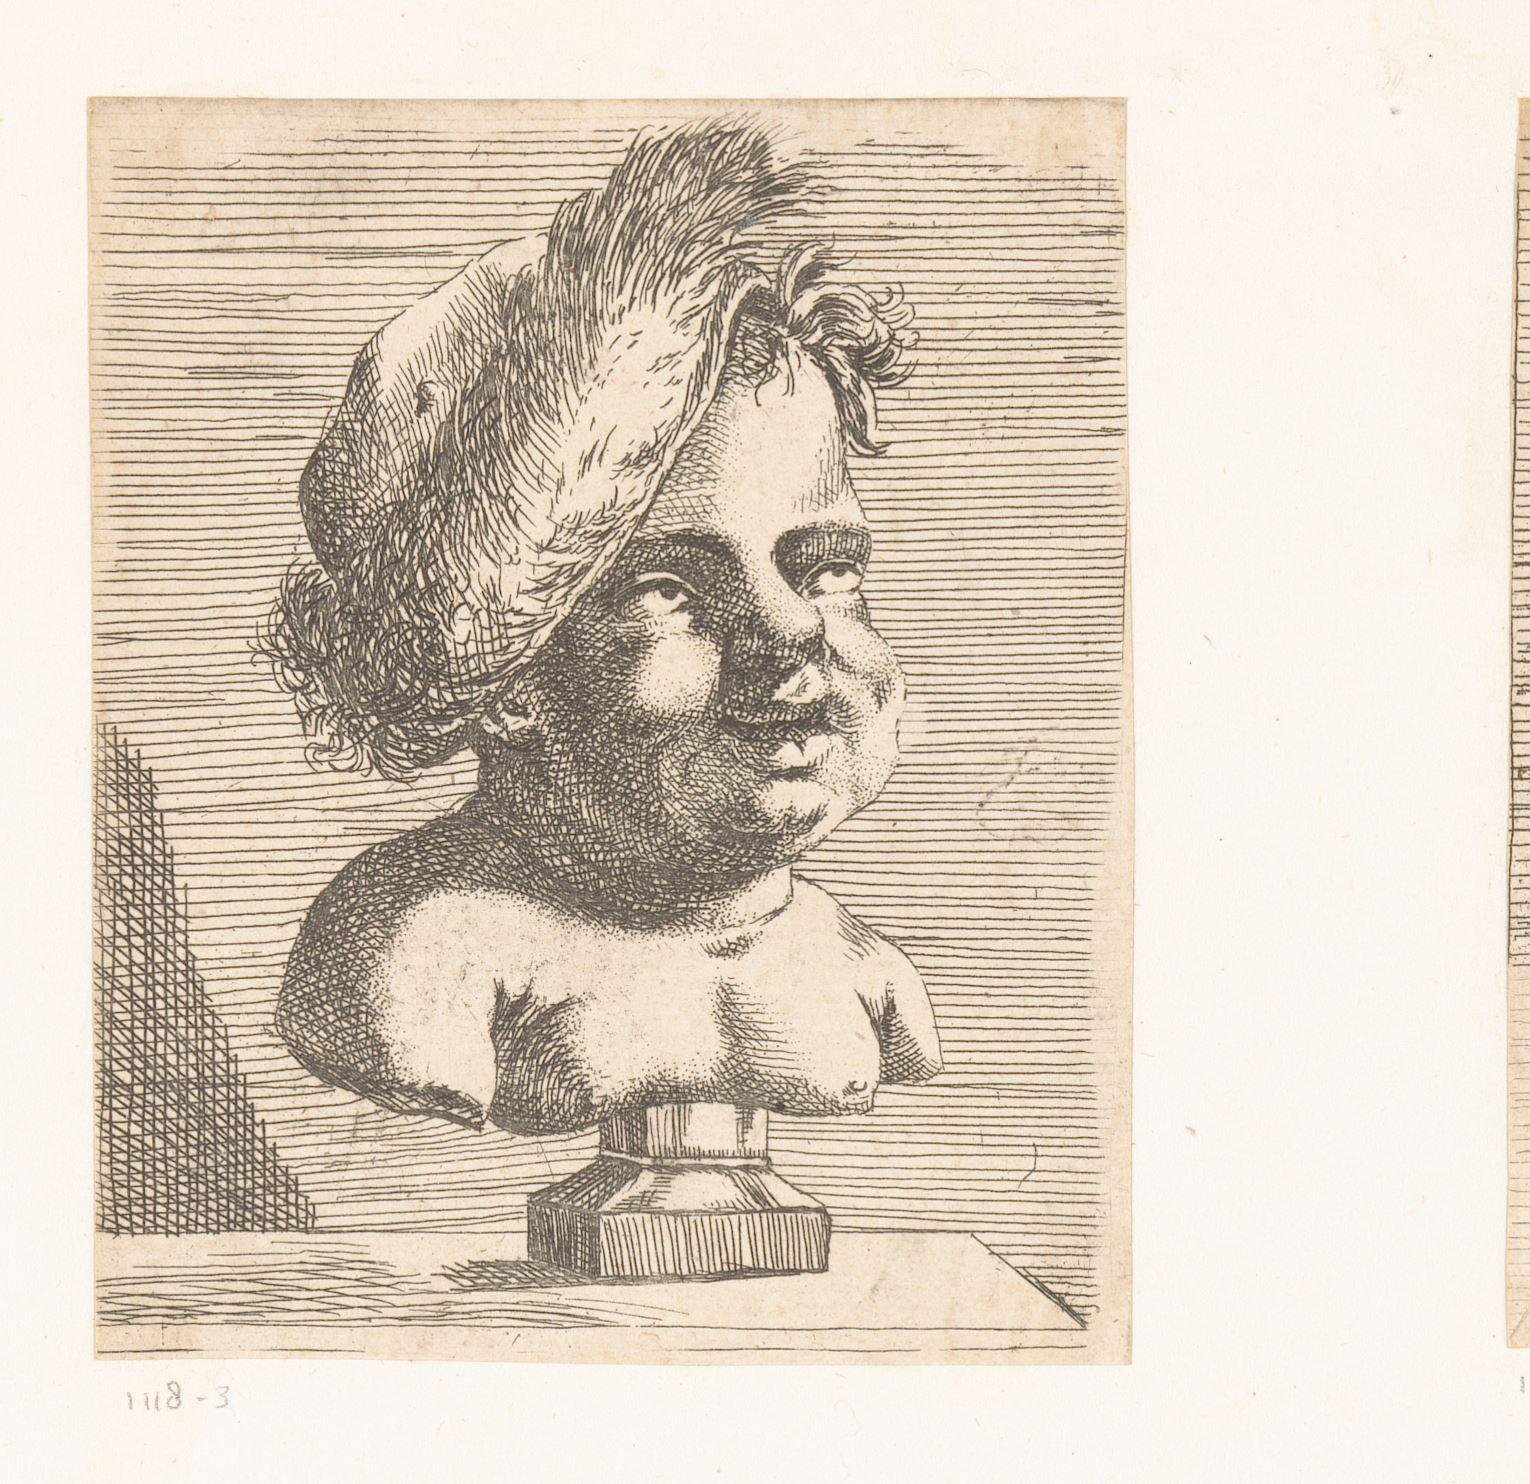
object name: print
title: Herm met kinderkop met baret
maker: françois bourlier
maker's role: draughtsman, painter, print maker, publisher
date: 1660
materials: paper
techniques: etching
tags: herms (garden ornaments), ornament ~ human parts, child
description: Herm met het hoofd van een kind met een baret. Onderdeel van een groep van negen bladen van zes verschillende kopjes.